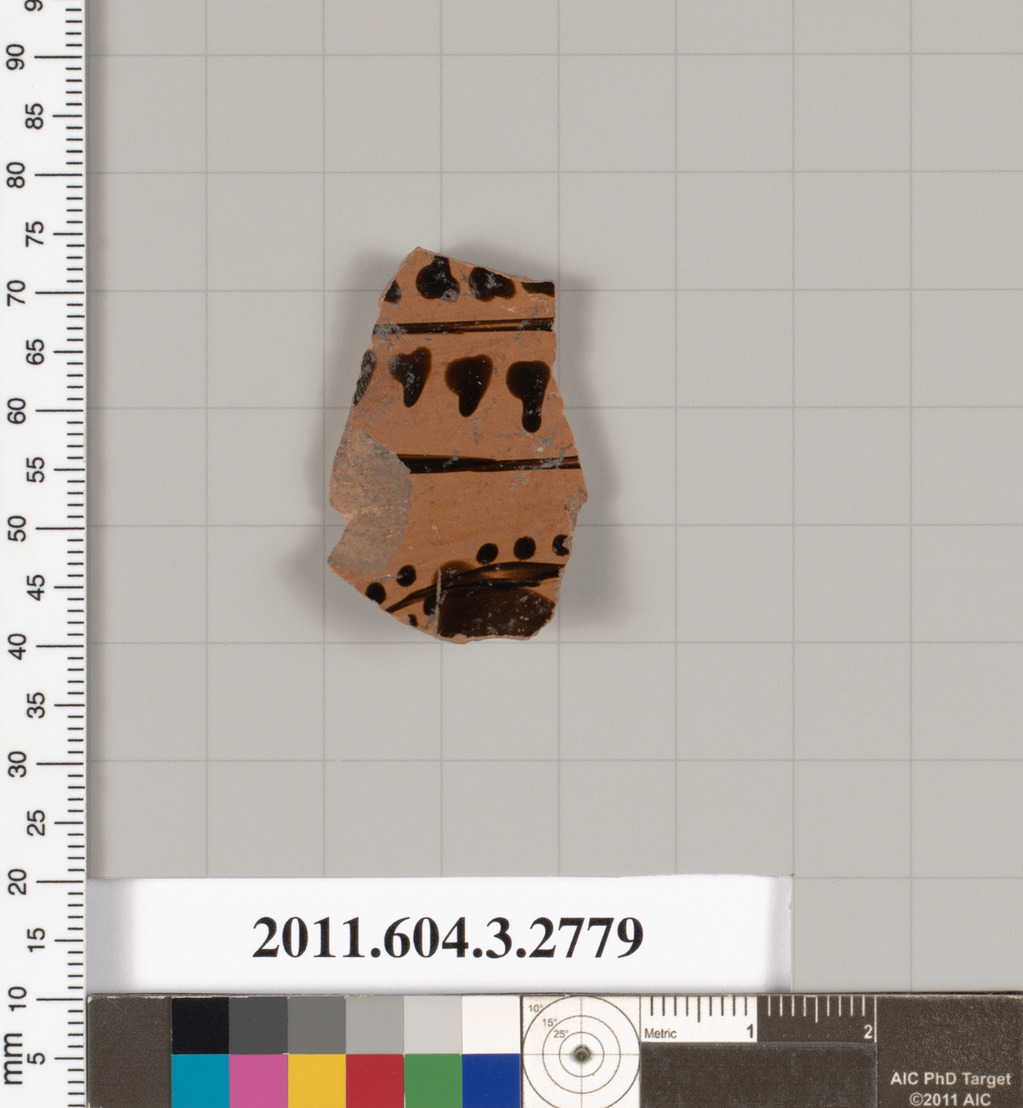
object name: olpe fragment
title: Terracotta fragment of an olpe (jug)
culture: greek, attic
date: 530-520 BCE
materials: terracotta